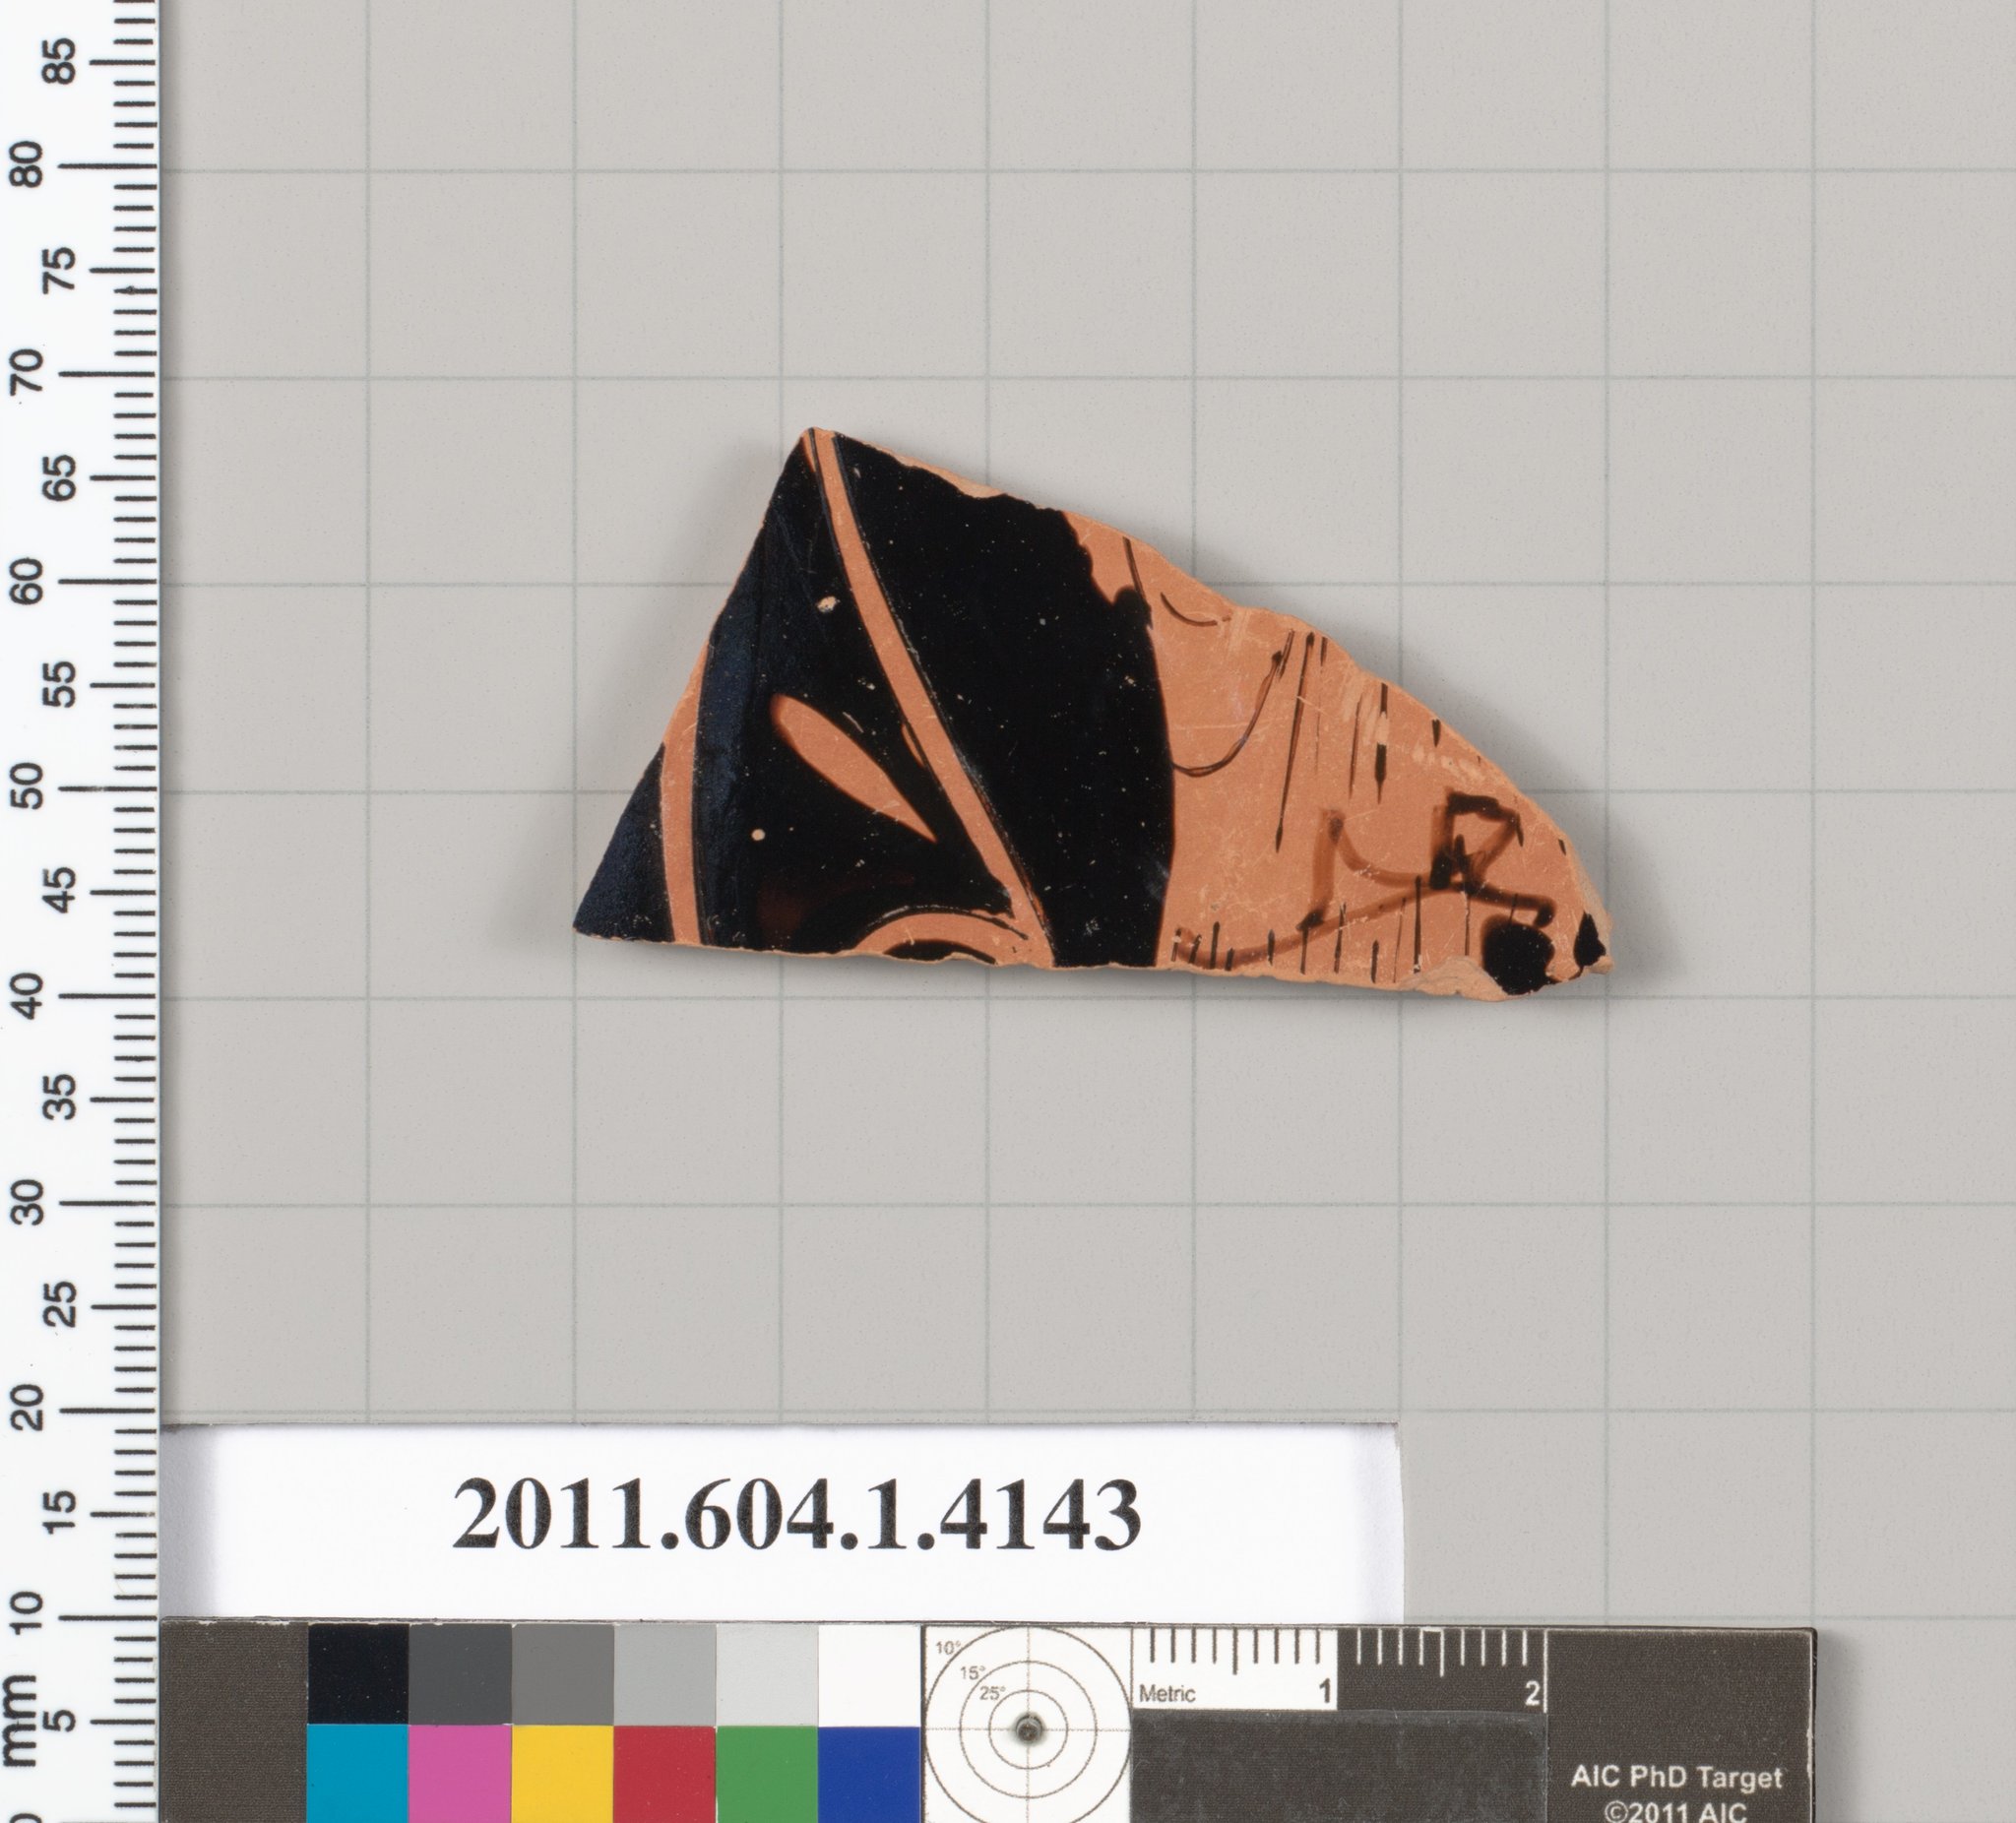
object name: kylix fragment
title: Terracotta fragment of a kylix (drinking cup)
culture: greek, attic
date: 475-451 BCE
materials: terracotta